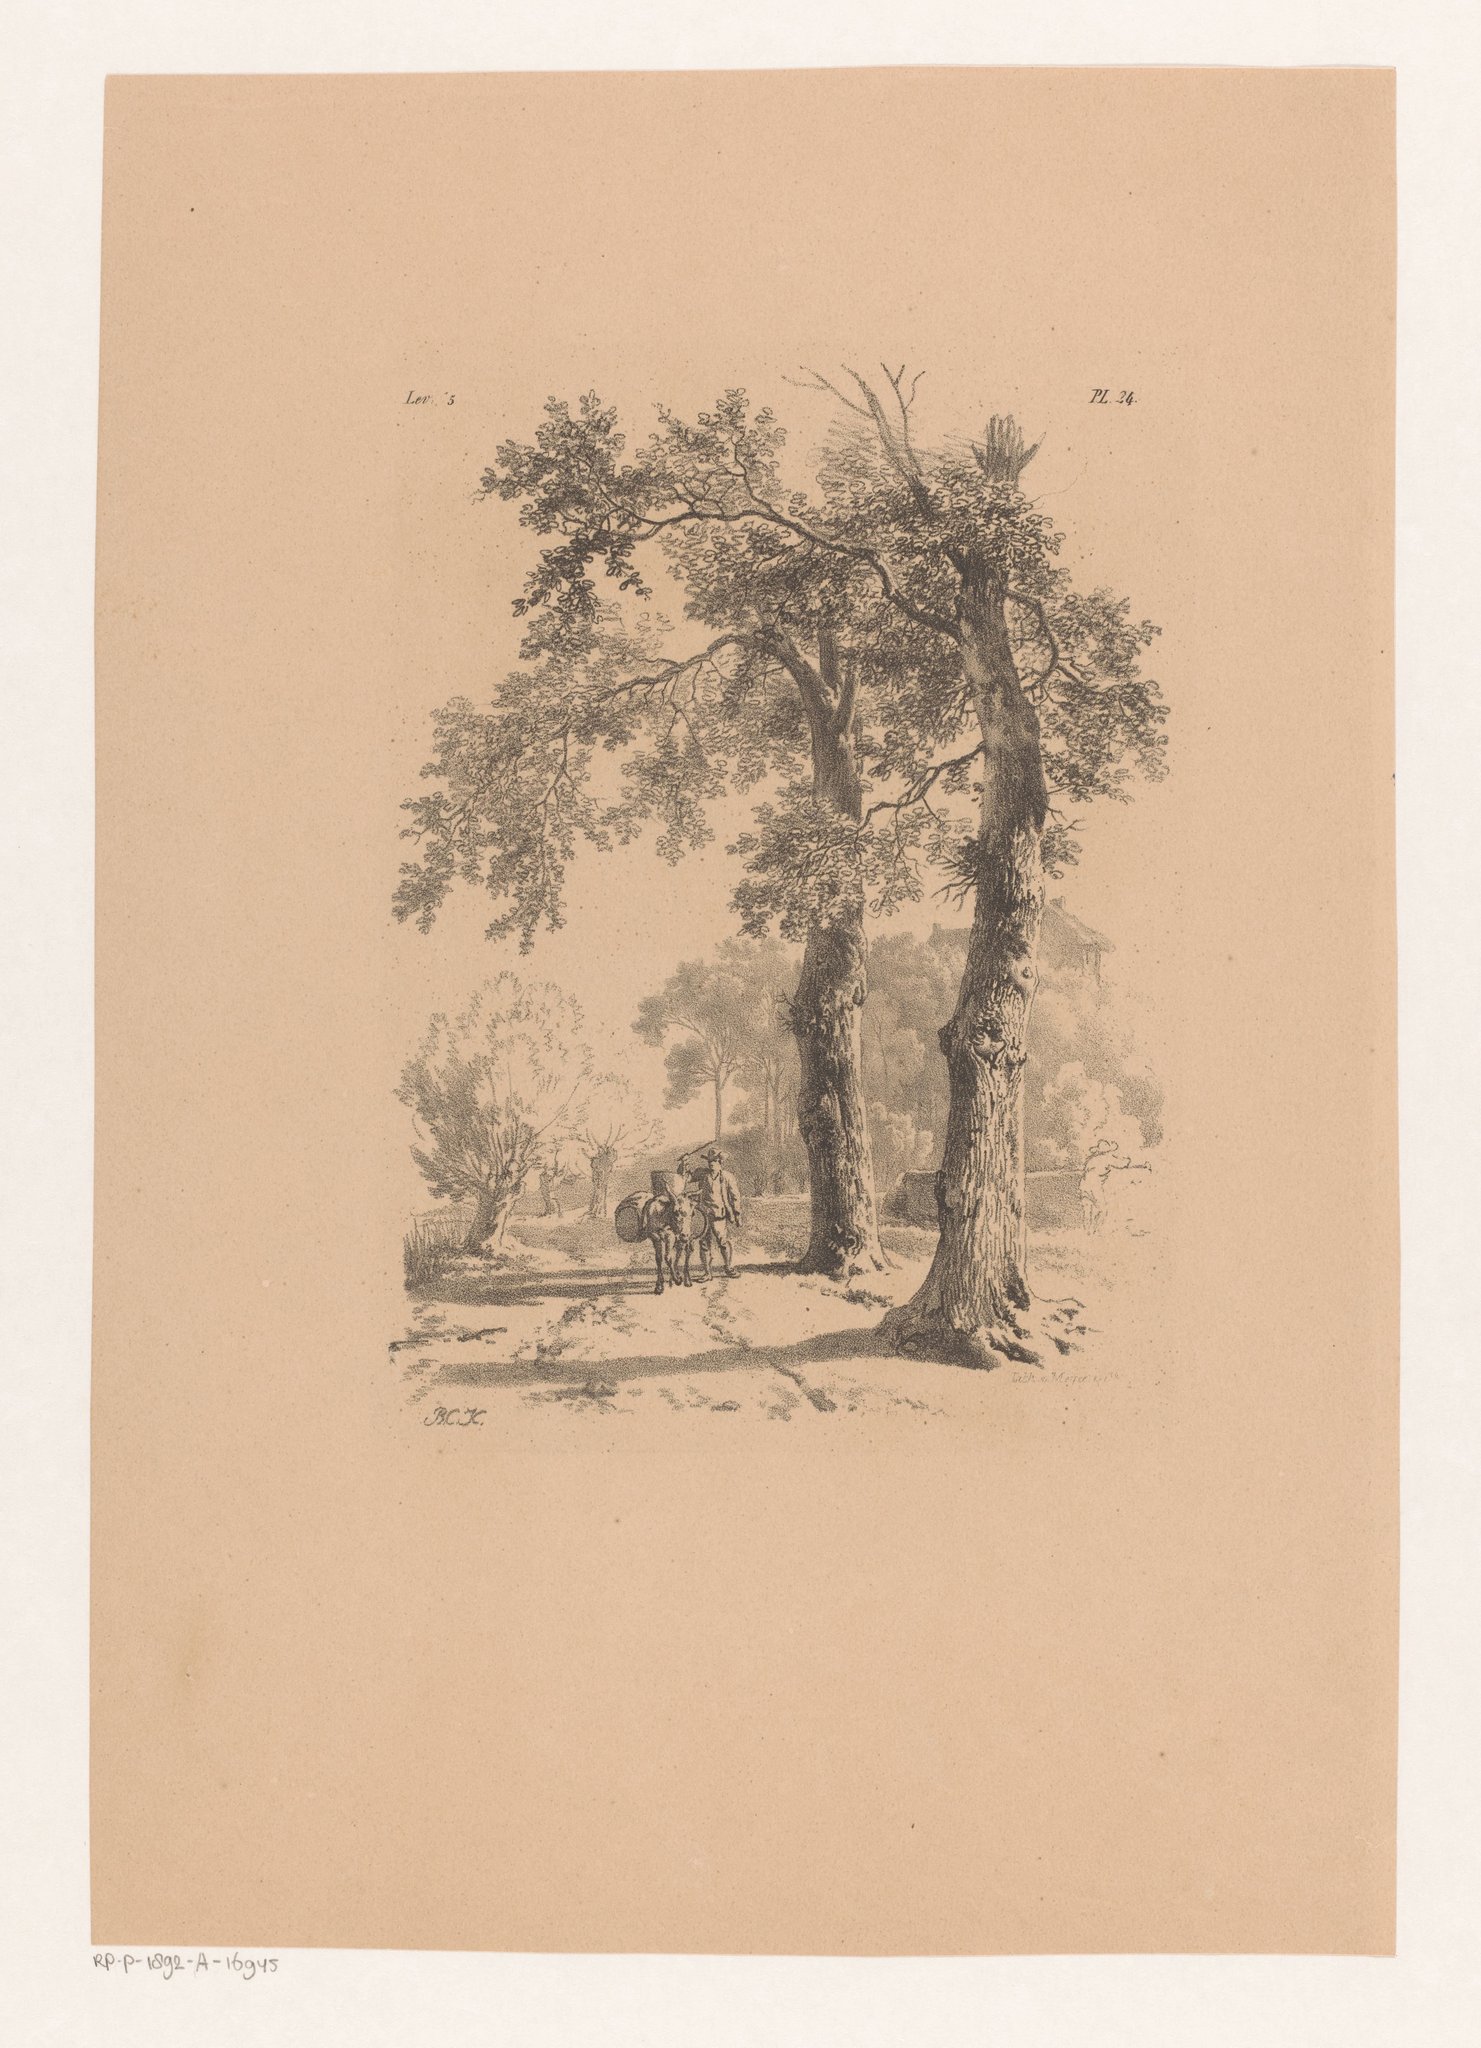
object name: print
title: Landschap studiën vijfde levering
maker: barend cornelis koekkoek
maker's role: draughtsman, painter, print maker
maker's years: 1803-1862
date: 1844-1845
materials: paper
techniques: lithograph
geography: amsterdam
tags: ass, donkey, forest path or lane (+ landscape with figures, staffage), public road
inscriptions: collector's mark: Lugt 2228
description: In 1829 en 1830 gaf Koekkoek, samen met Daiwaille, zes cahiers uit met ieder zes prenten getiteld Landschapstudiën. Deze werden gebruikt in het tekenonderwijs. Vijftien jaar later werd deze reeks, in een andere samenstelling nogmaals uitgegeven door Meyer en Comp in Amsterdam. Zie: De Bruyn Kops, 1963.